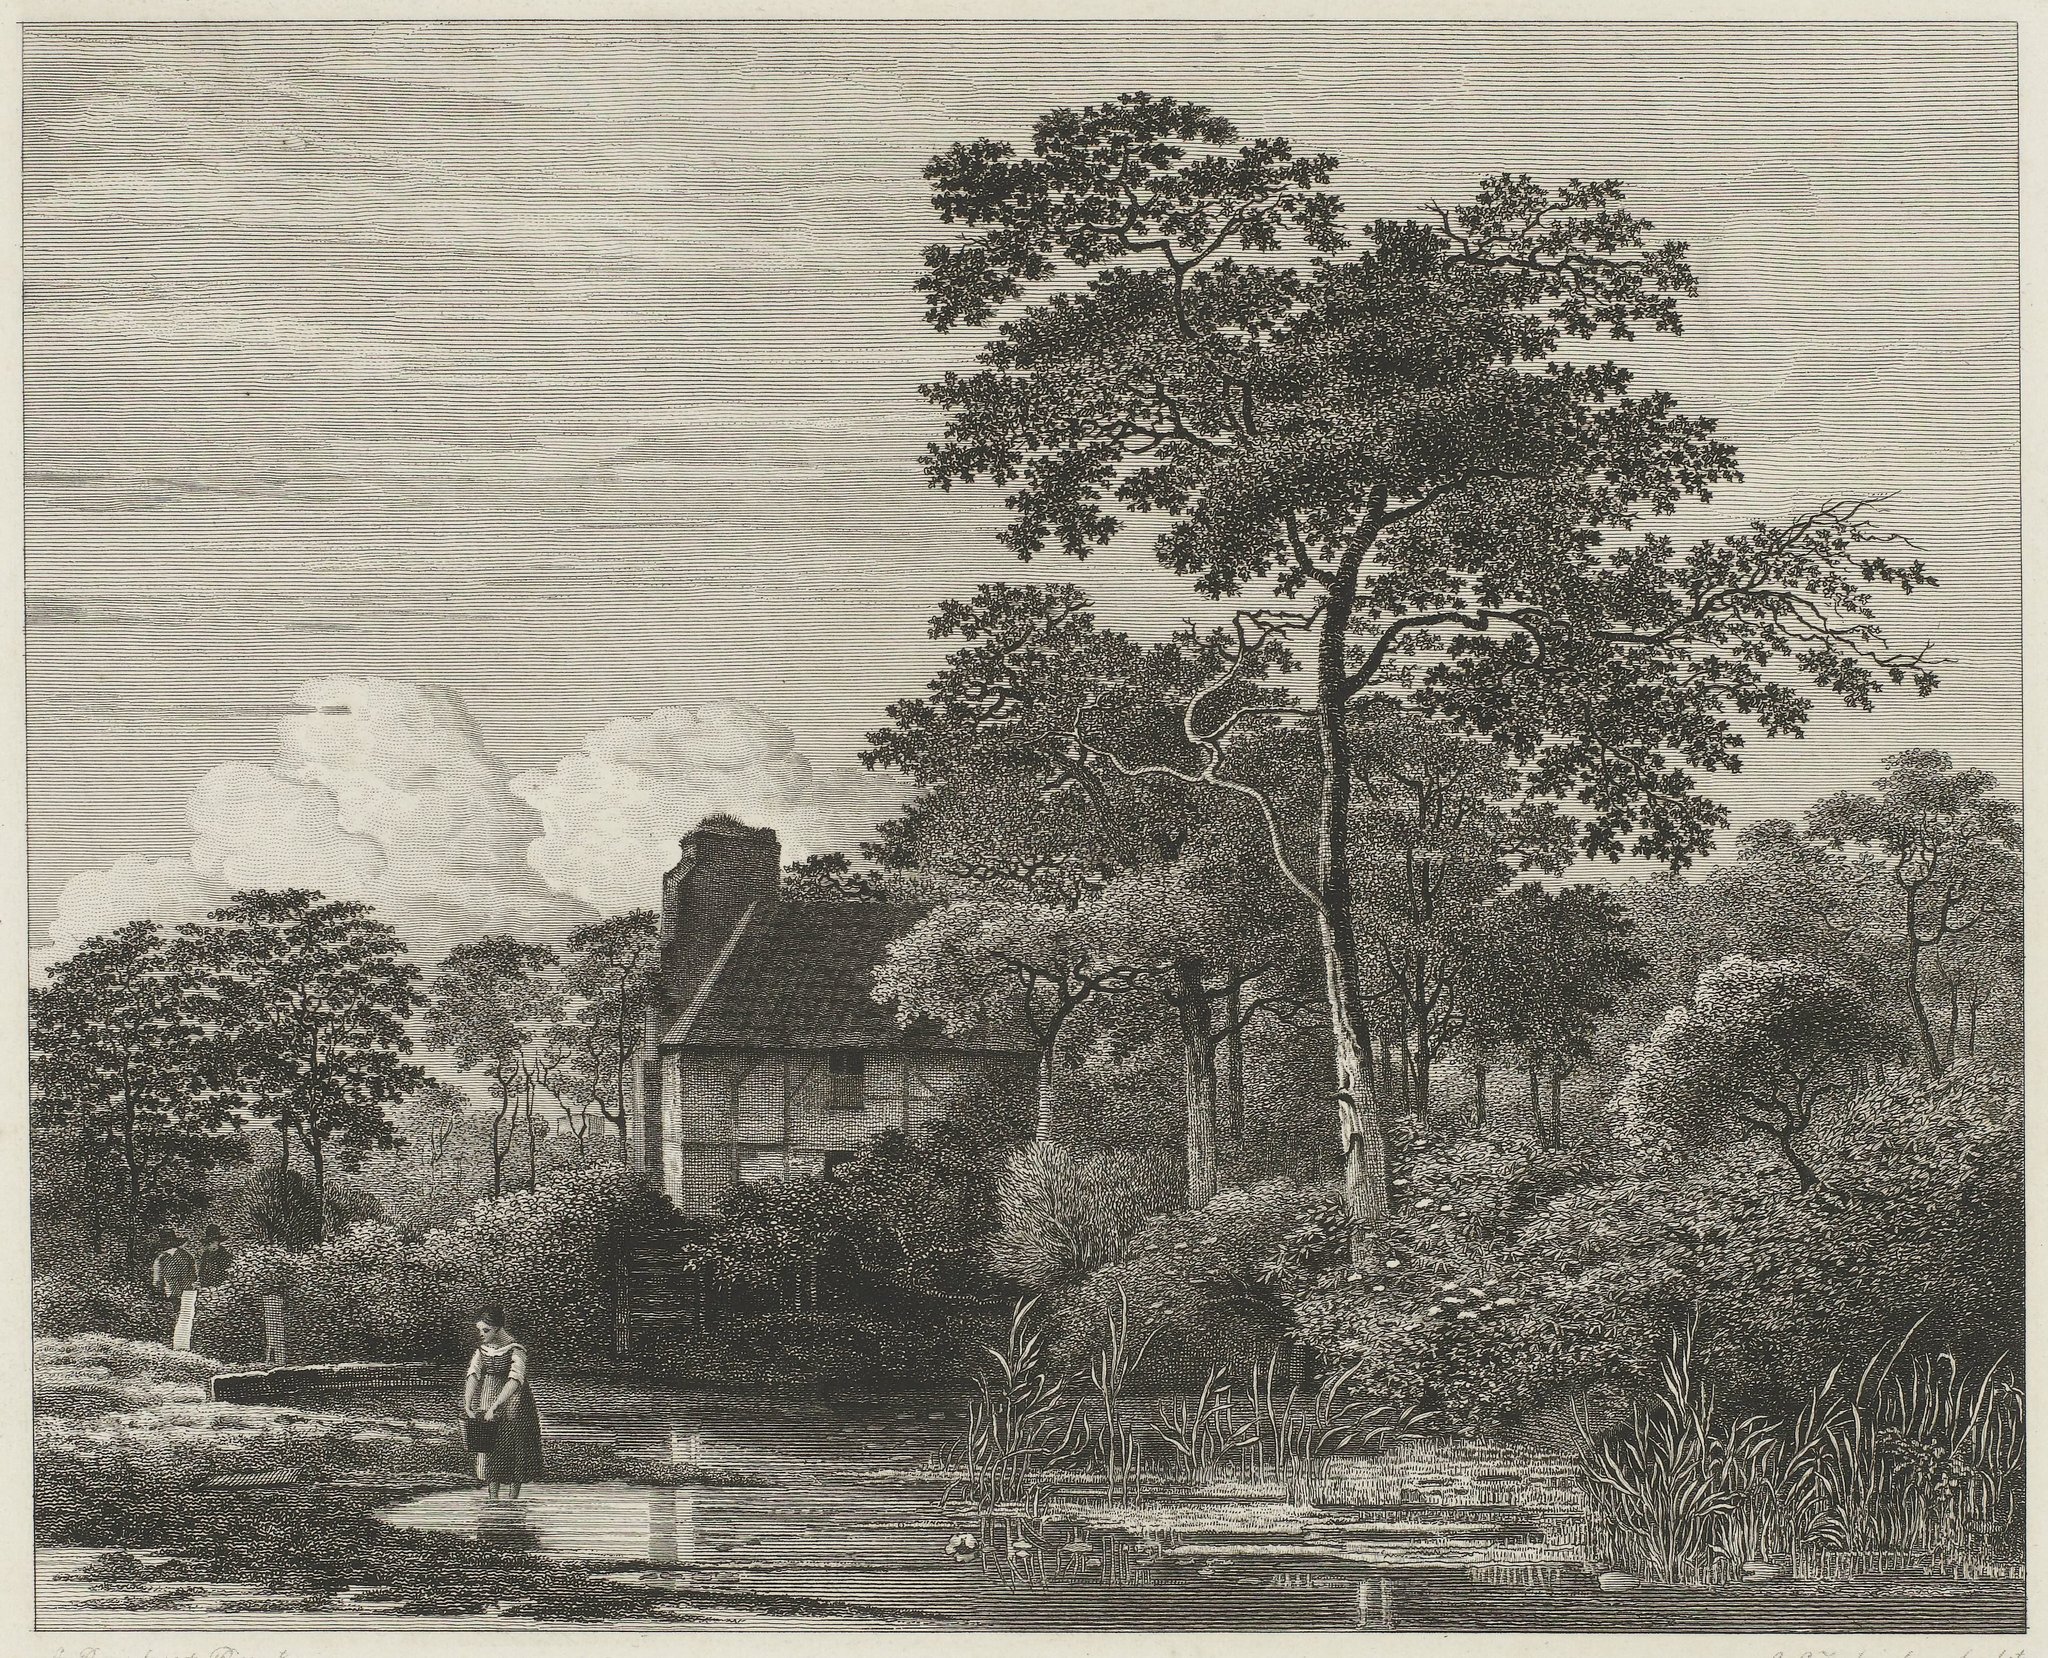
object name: print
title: Landschap met beek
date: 1830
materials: paper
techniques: etching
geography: amsterdam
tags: brook, farm or solitary house in landscape, container of metal: bucket, can, canister, drum, tin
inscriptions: collector's mark: Lugt 2760, collector's mark: Lugt 2228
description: Landschap met vakwerkhuis en beek, met daarin een staand wasmeisje met emmer.